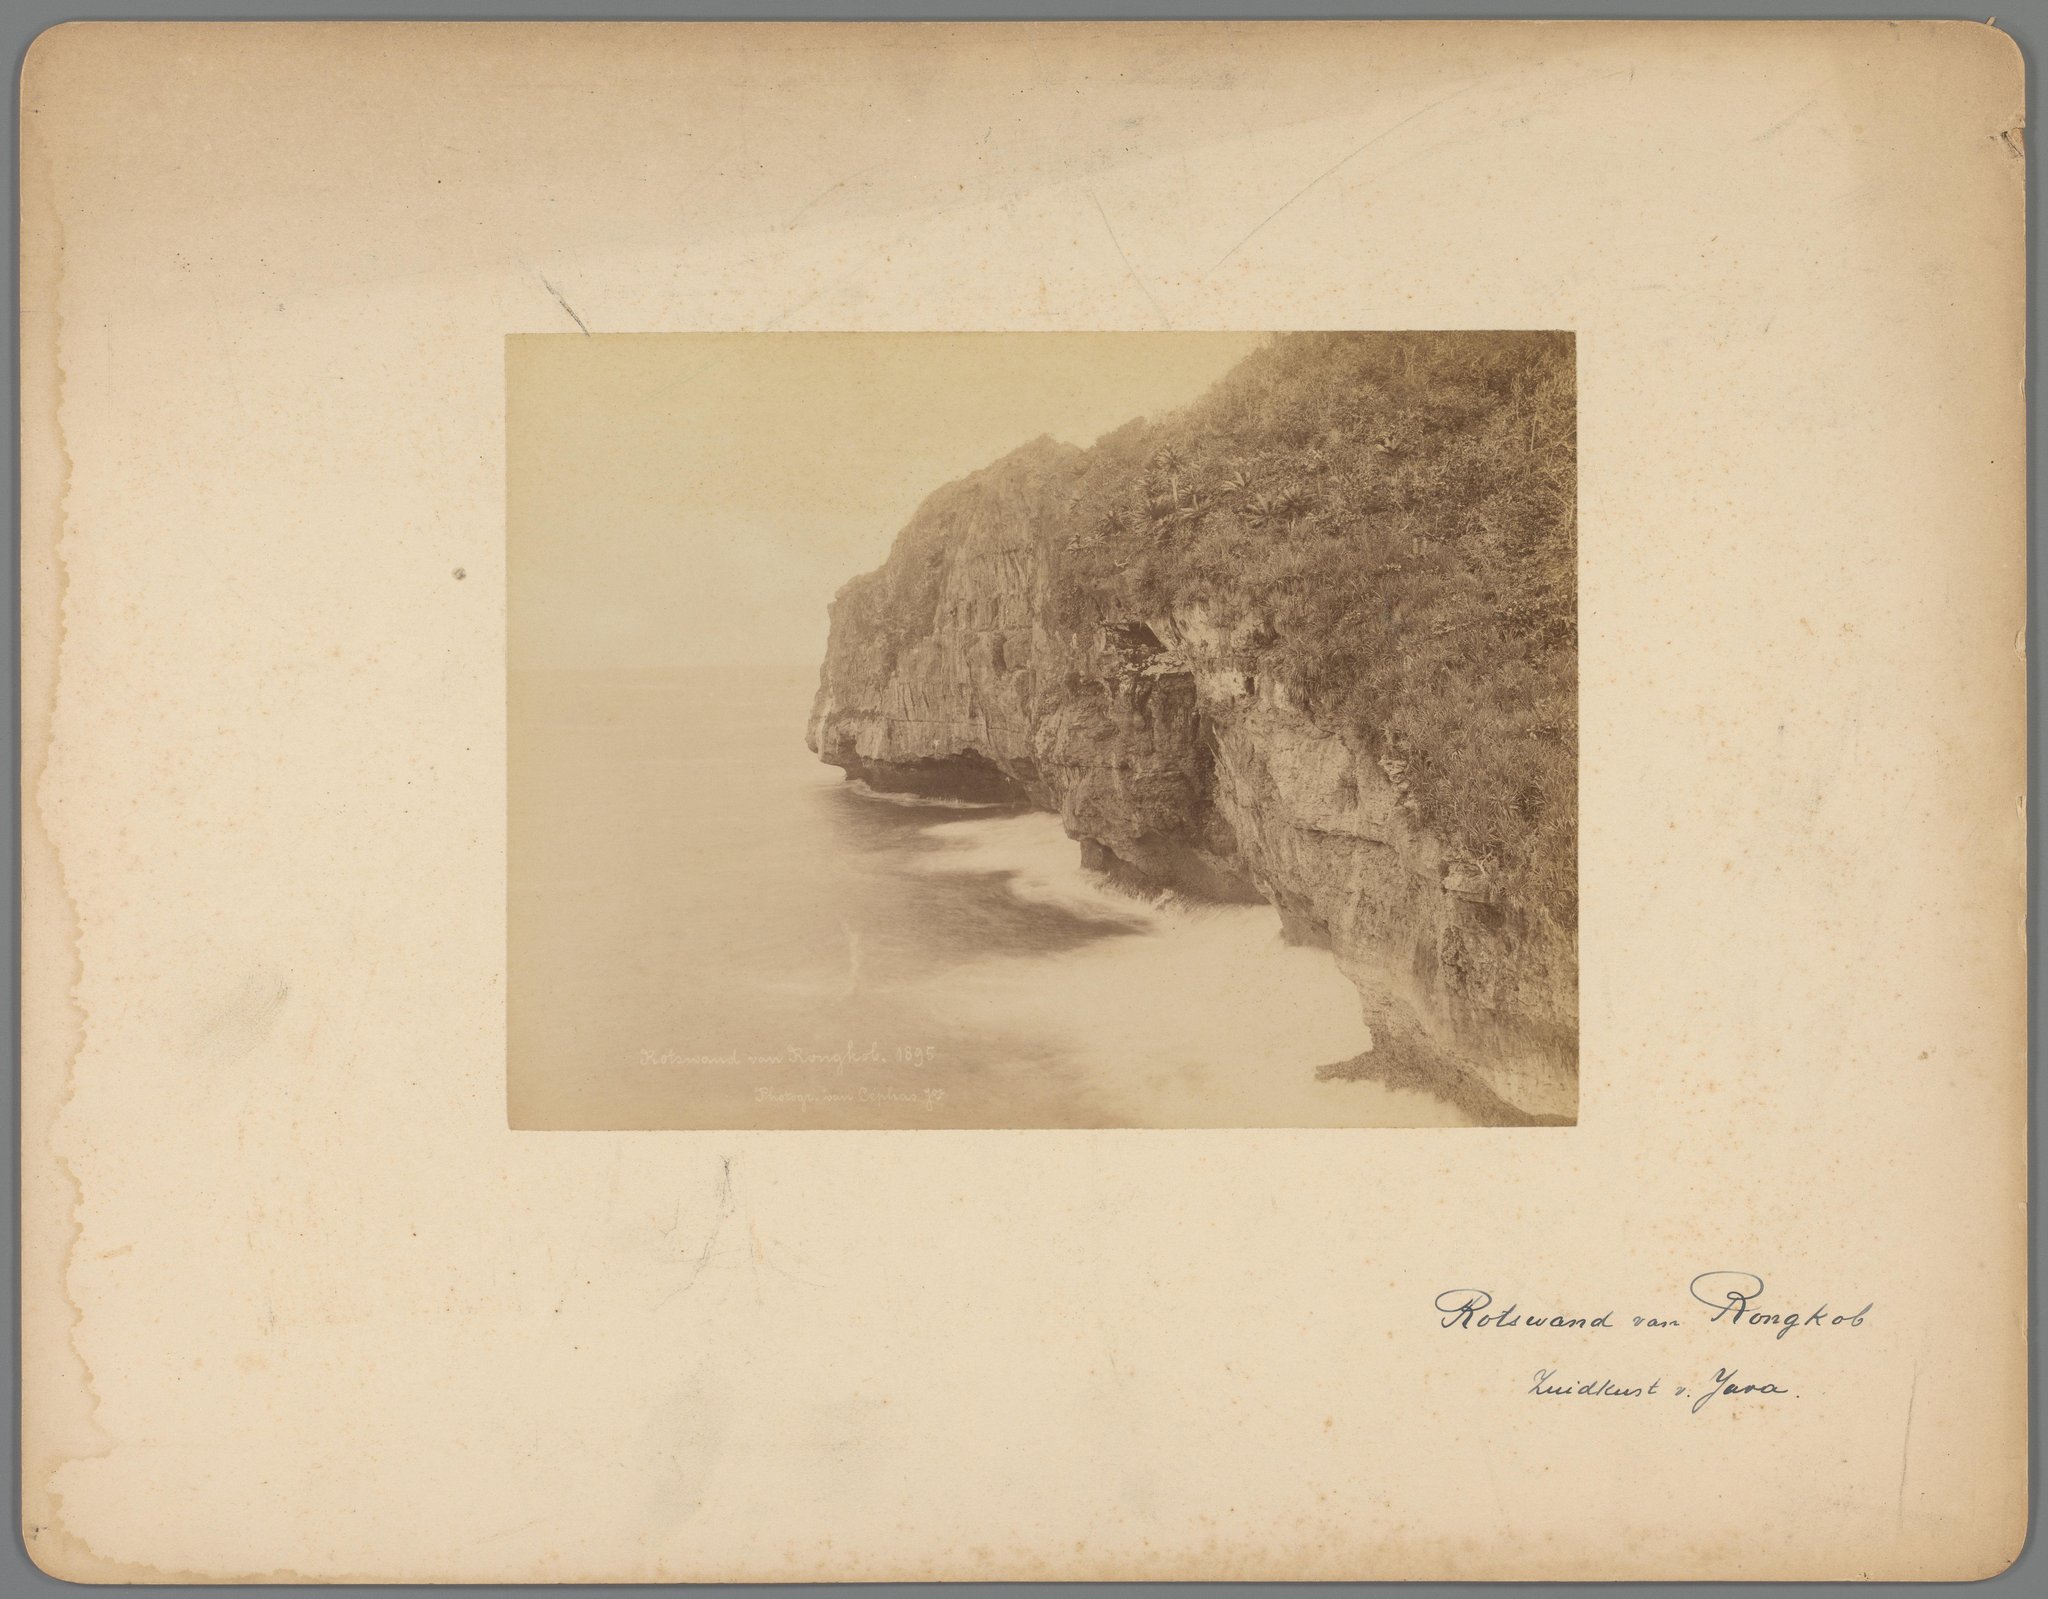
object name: photograph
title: Rotswand van Rongkob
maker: kassian céphas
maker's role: fotograaf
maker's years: 1845-1912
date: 1895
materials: cardboard, paper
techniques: albumen print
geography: java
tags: gulf, bay, rock-formations, java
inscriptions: inscription: ‘FOTO’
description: Deze foto zat oorspronkelijk in prentenkabinet RP-F-AA3192.